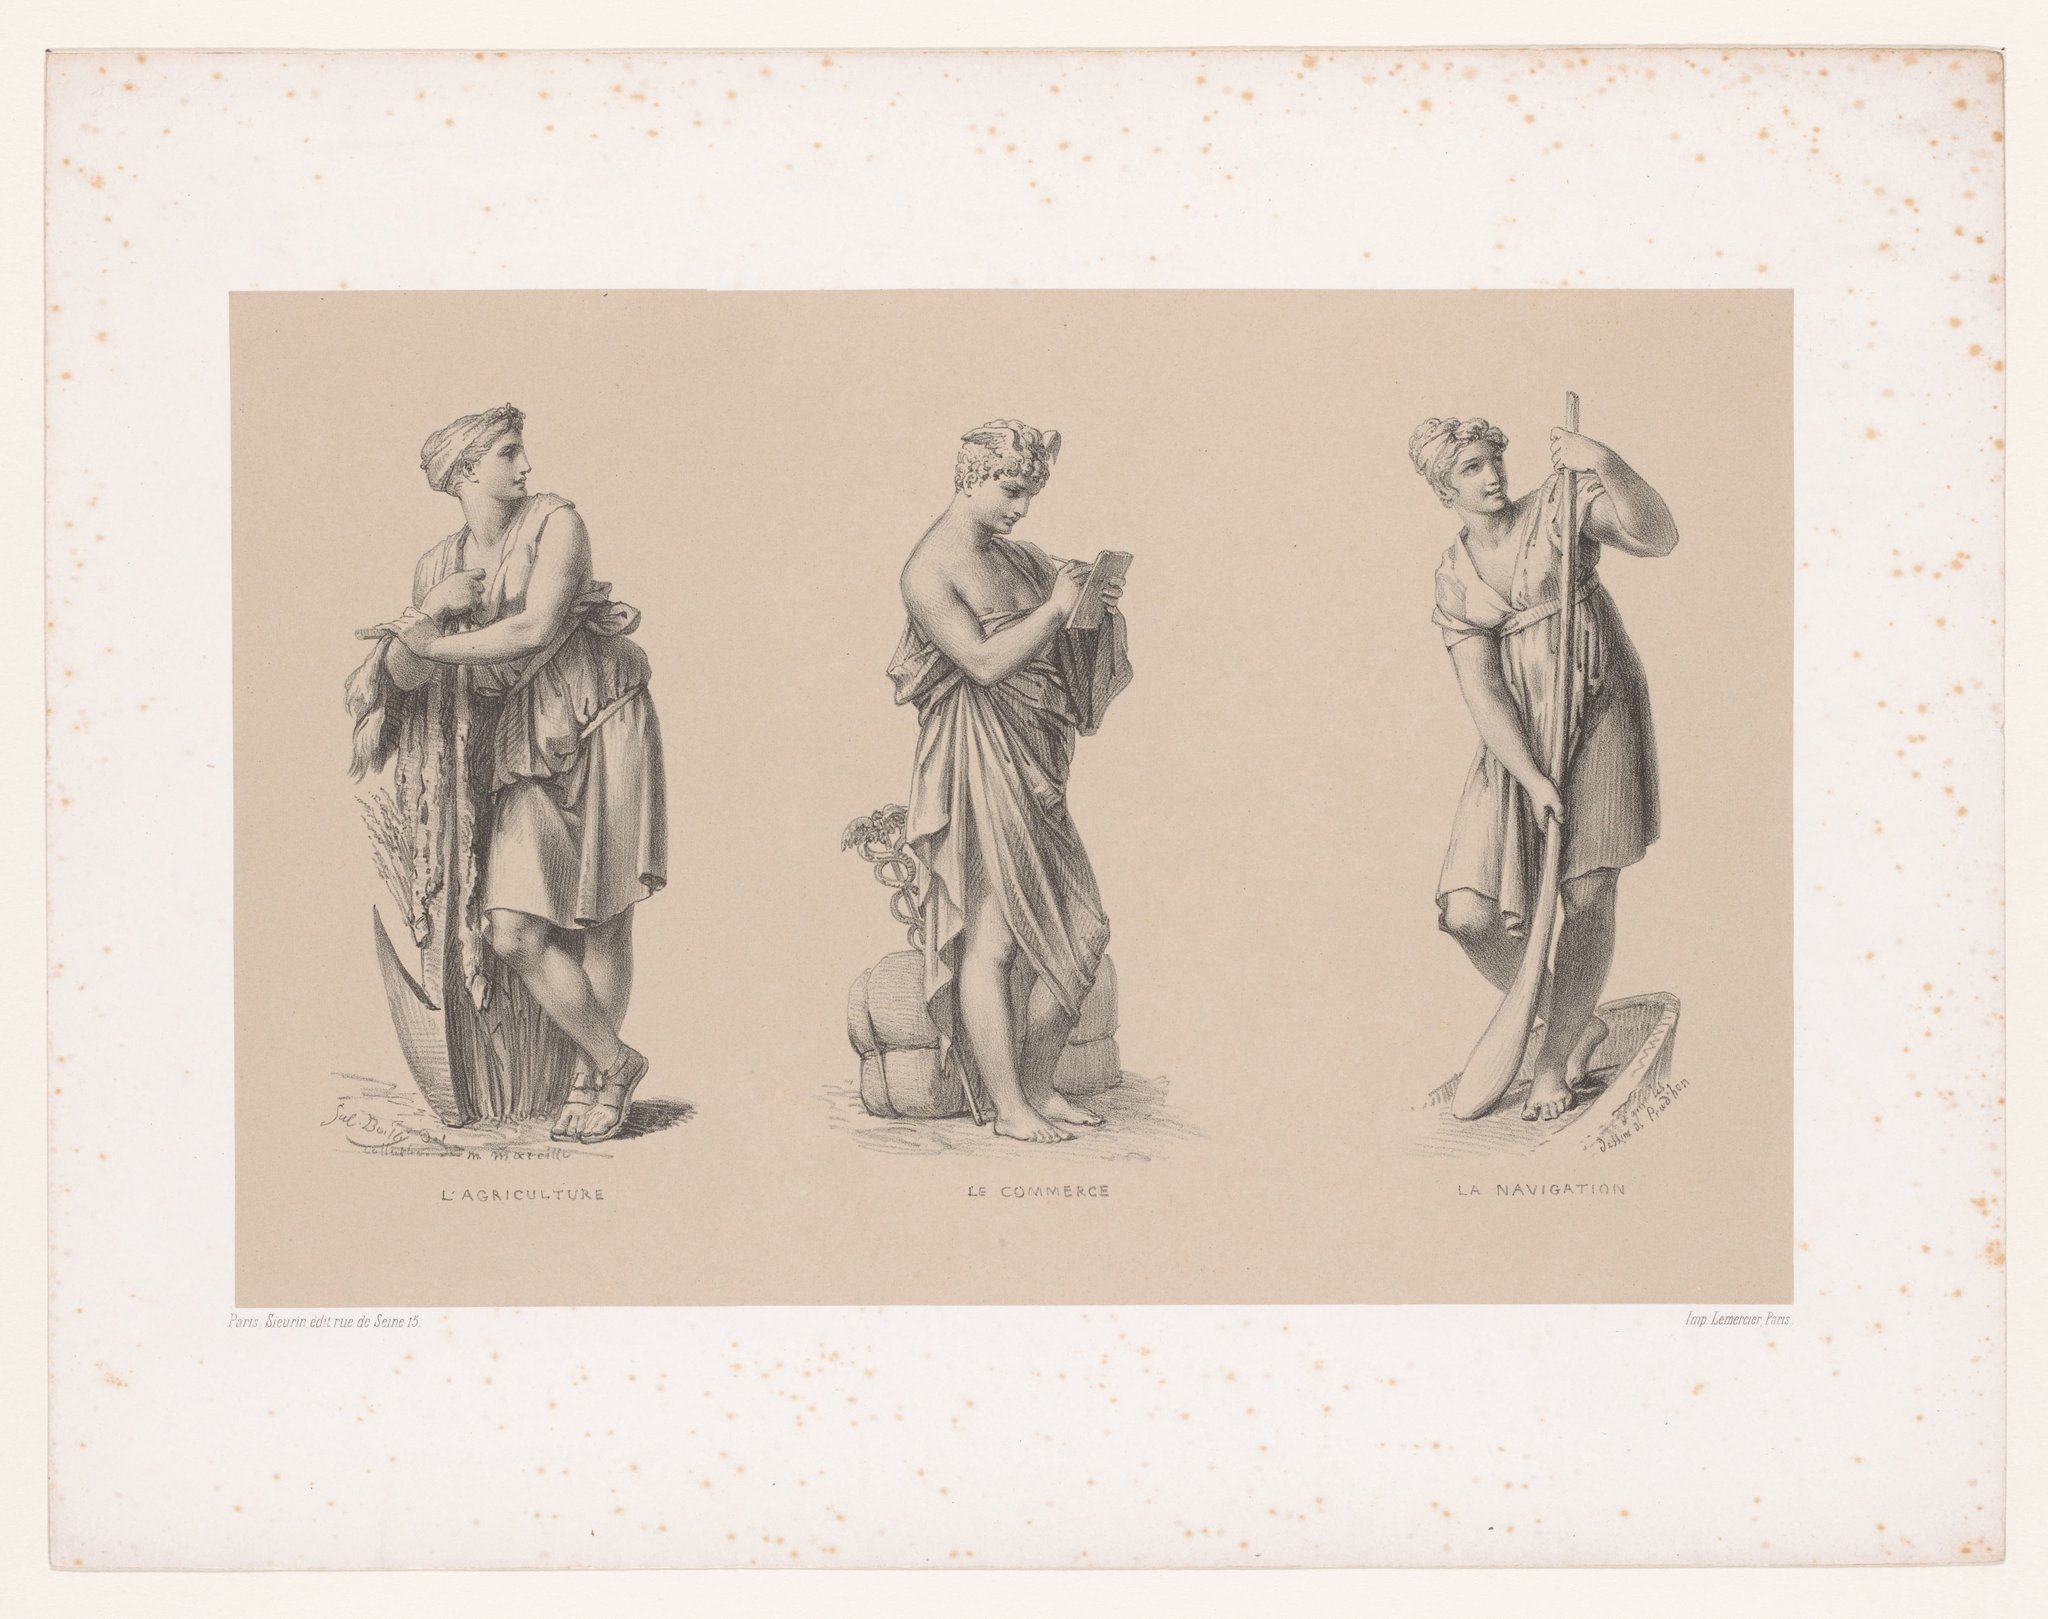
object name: print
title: L'Agriculture/ le Commerce/ la Navigation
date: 1855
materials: paper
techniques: lithograph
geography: paris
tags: personification of agriculture, 'agricultura'; 'agricoltura', 'studio dell'agricoltura' (ripa), allegory of trade; 'commertio della vita humana' (ripa), 'navigatione' (ripa)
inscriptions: collector's mark: Lugt 2228